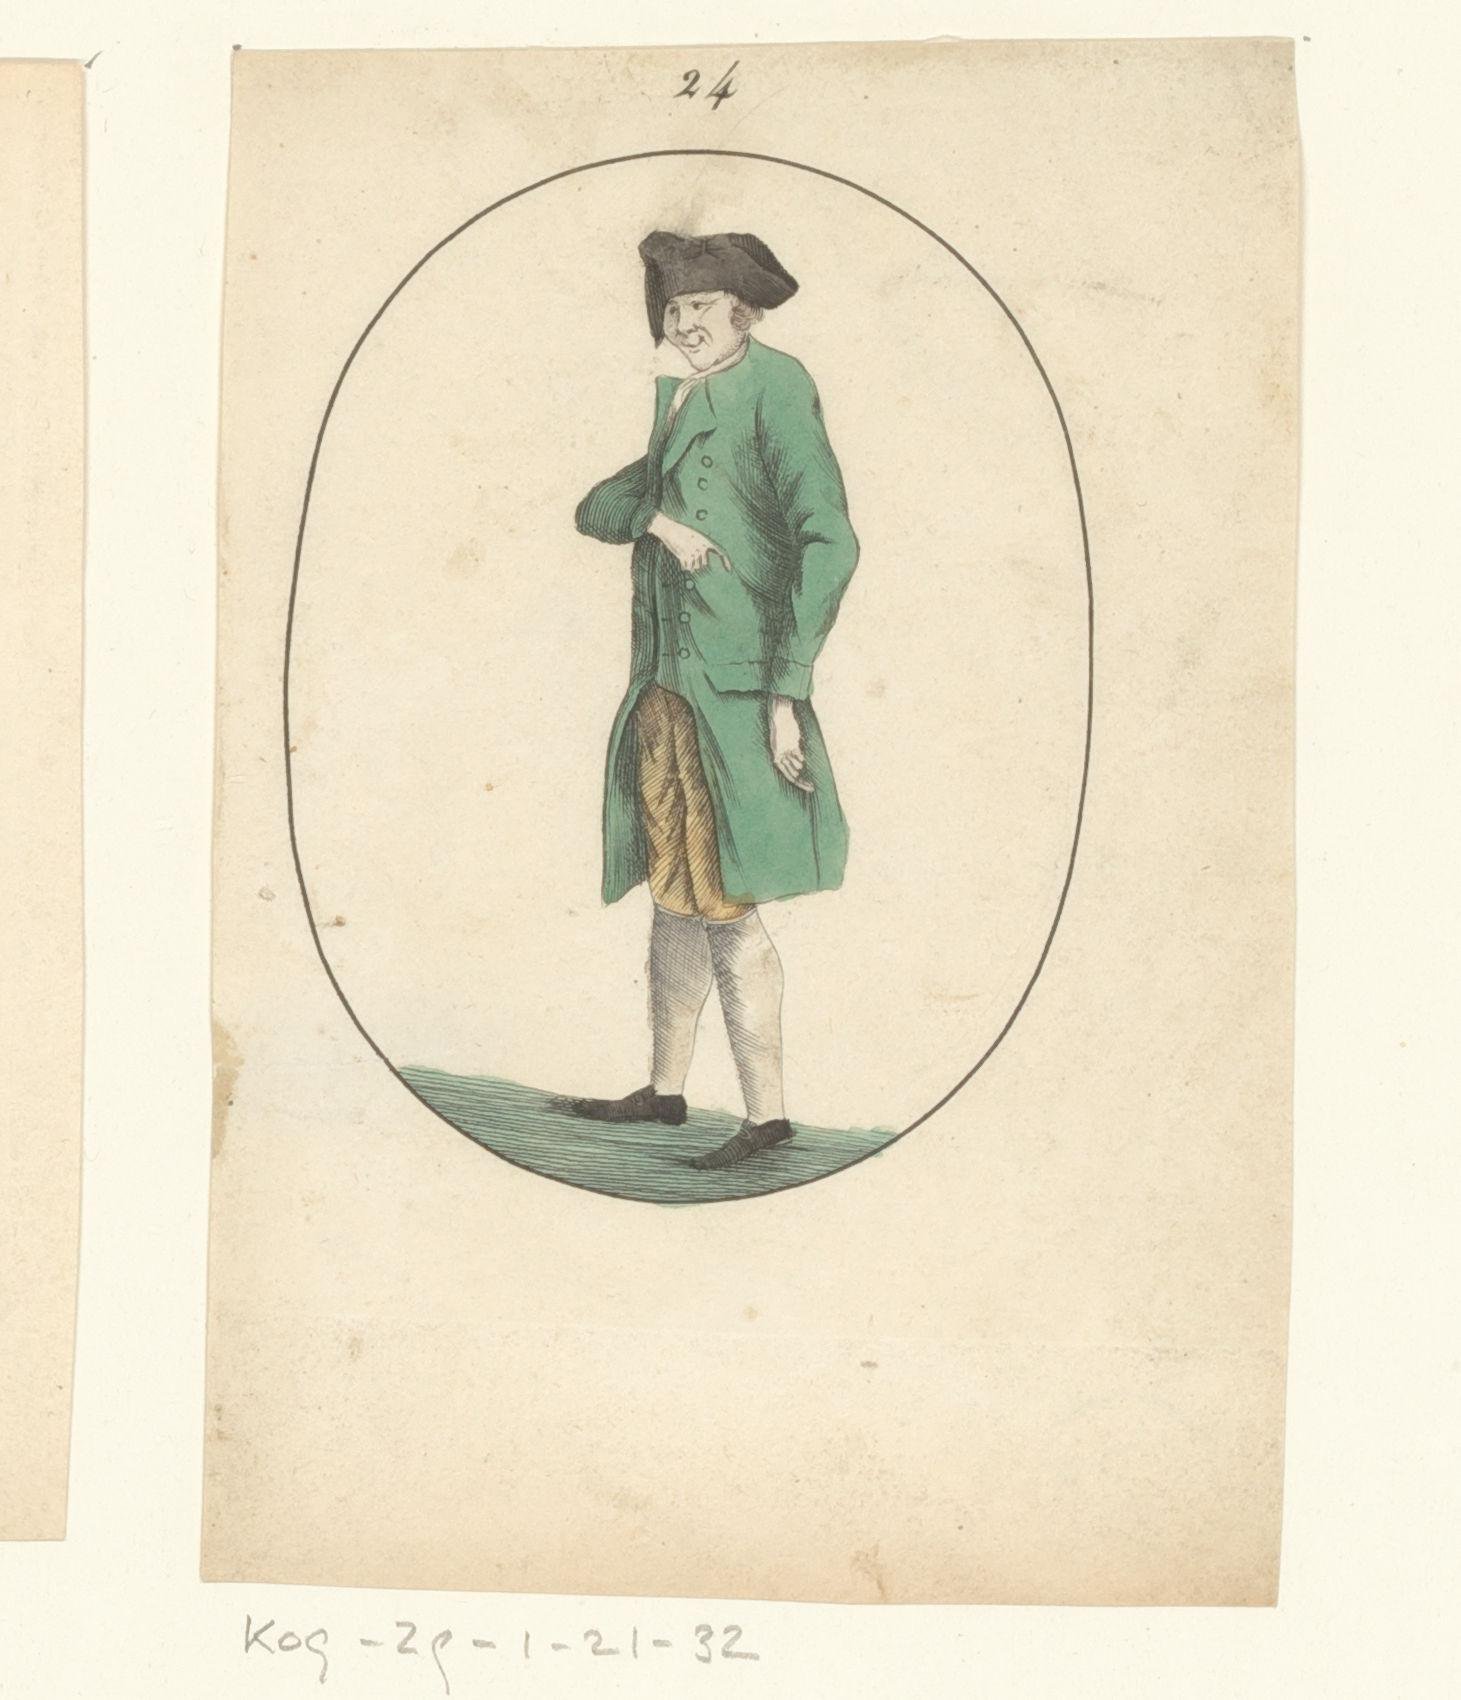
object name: print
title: Staande man wijst naar zijn arm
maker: Anonymous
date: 1750-1849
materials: paper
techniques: etching, hand coloring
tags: standing figure (+ sideview, profile), head-gear: tricorn, coat, historical costume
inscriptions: stamp, collector's mark: Lugt 1641a, collector's mark: Lugt 1641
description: Bovenaan genummerd: 24. Onderwerpsrubrieken binnen de Atlas Zeden en Gewoonten: Zeden en Gewoonten in Engeren Zin, De Kleeding, Kleederdrachten (tijdvakken), De 18de eeuw (de pruikentijd). Mannen en vrouwen.